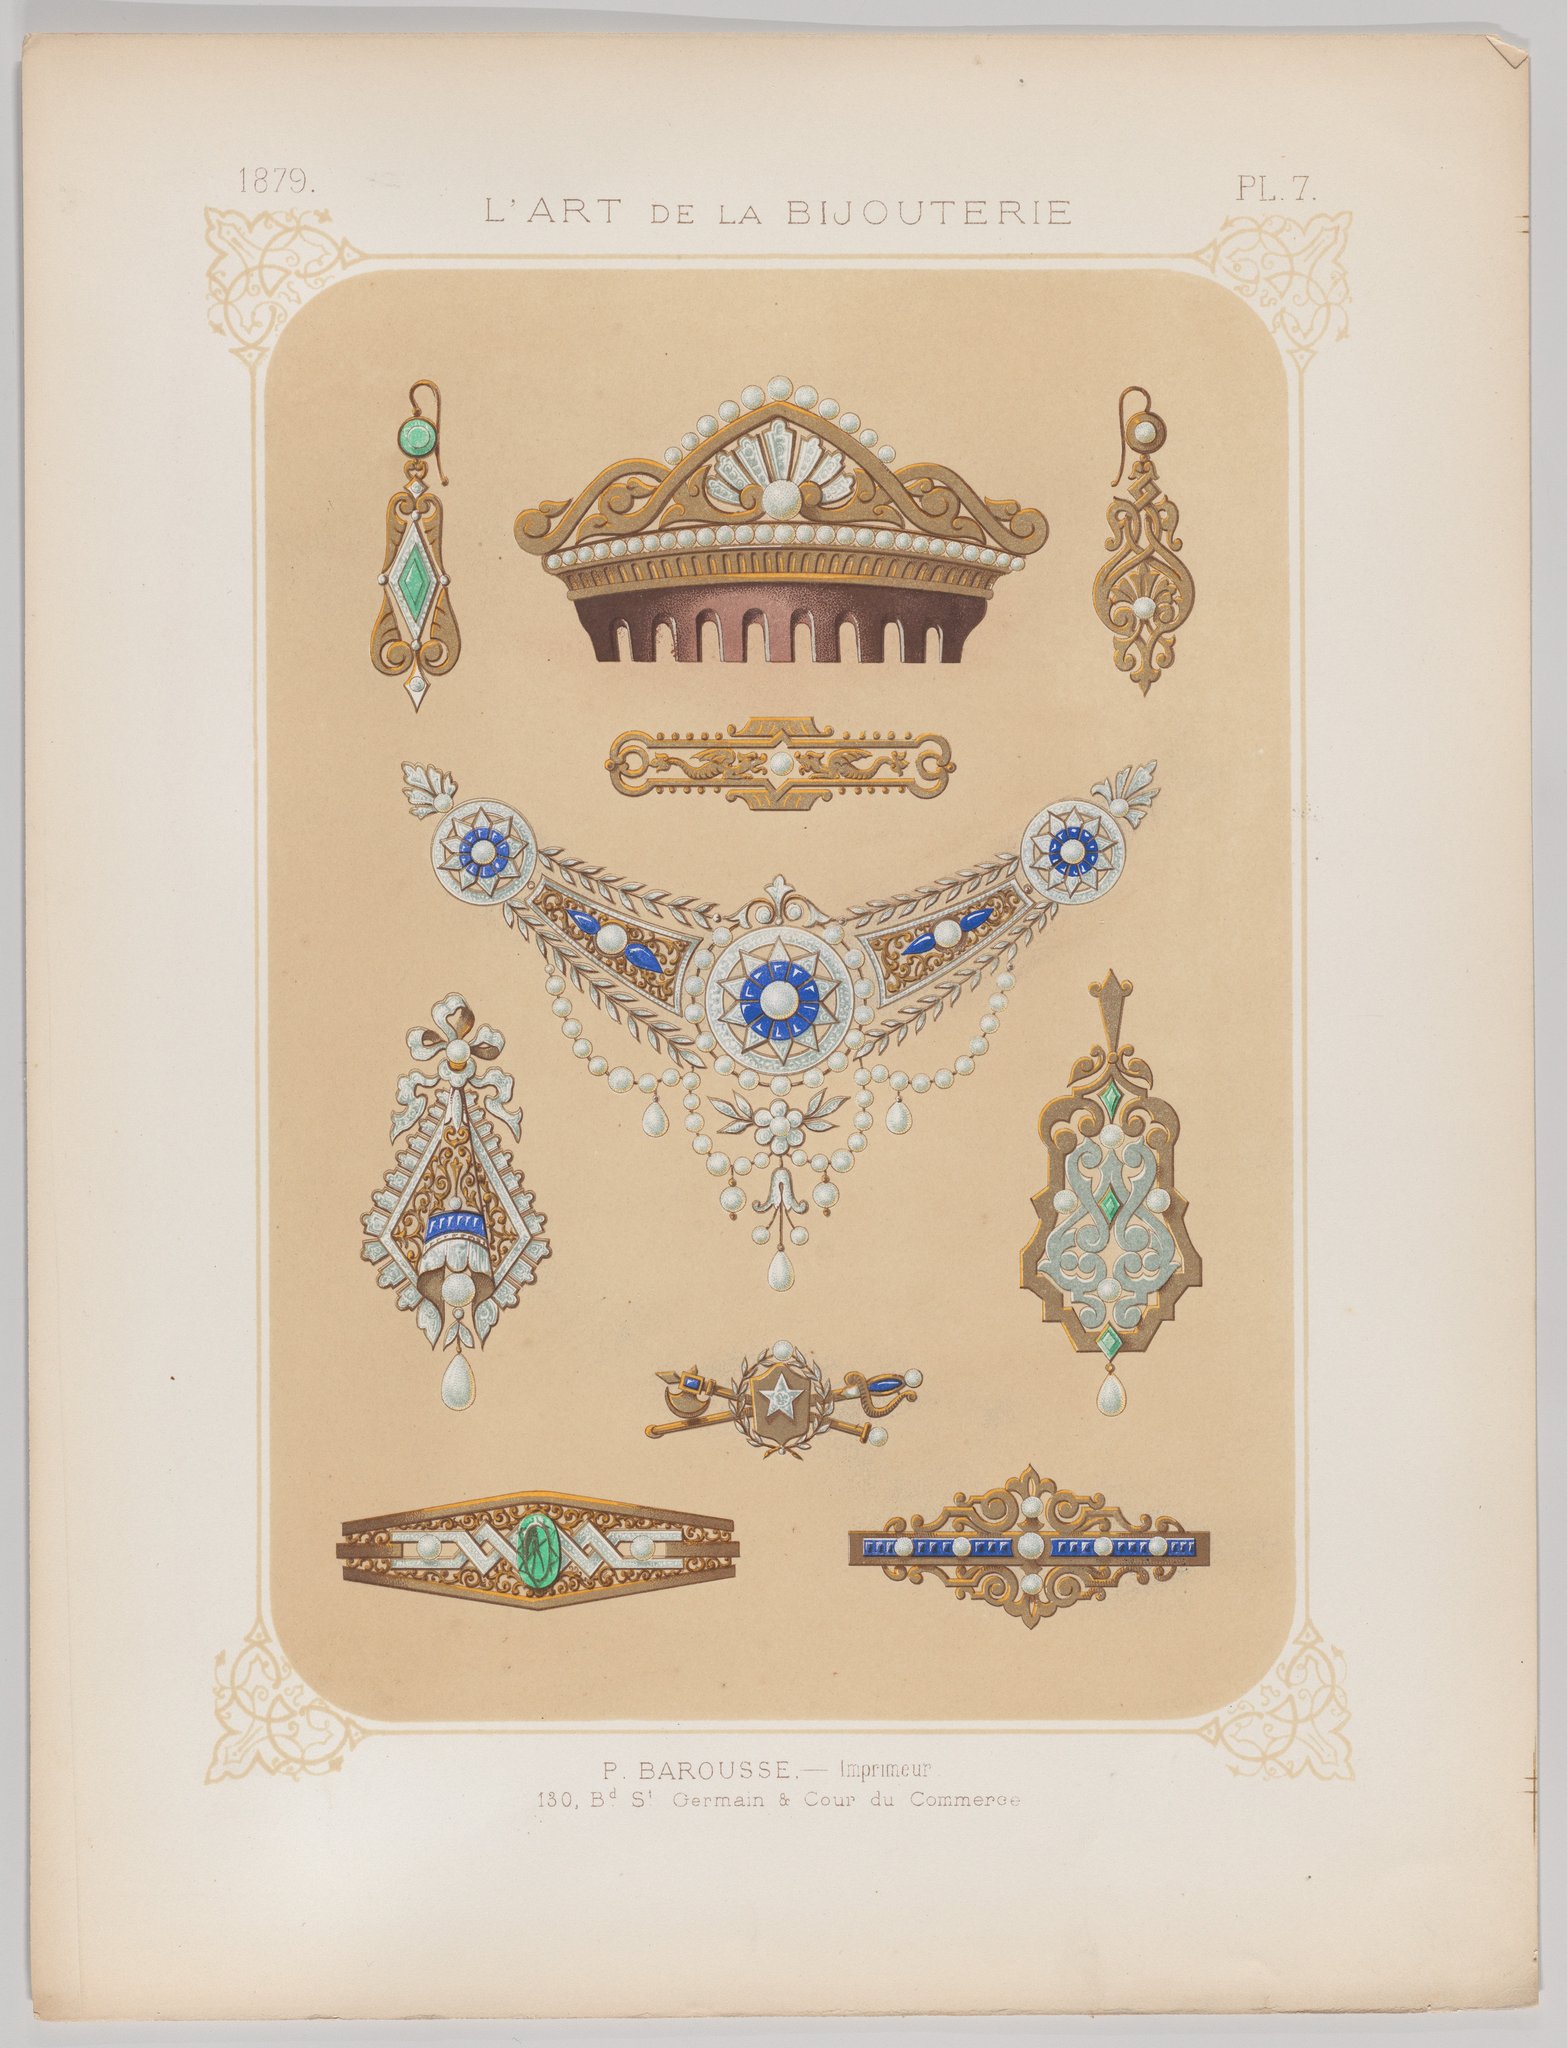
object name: print ornament architecture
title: Jewelry Designs in Gold, Diamonds and Other Precious Stones, Plate 7 from "L'Art de la Bijouterie"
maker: jean francois barousse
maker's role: printer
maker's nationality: french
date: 1879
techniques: lithograph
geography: france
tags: jewelry